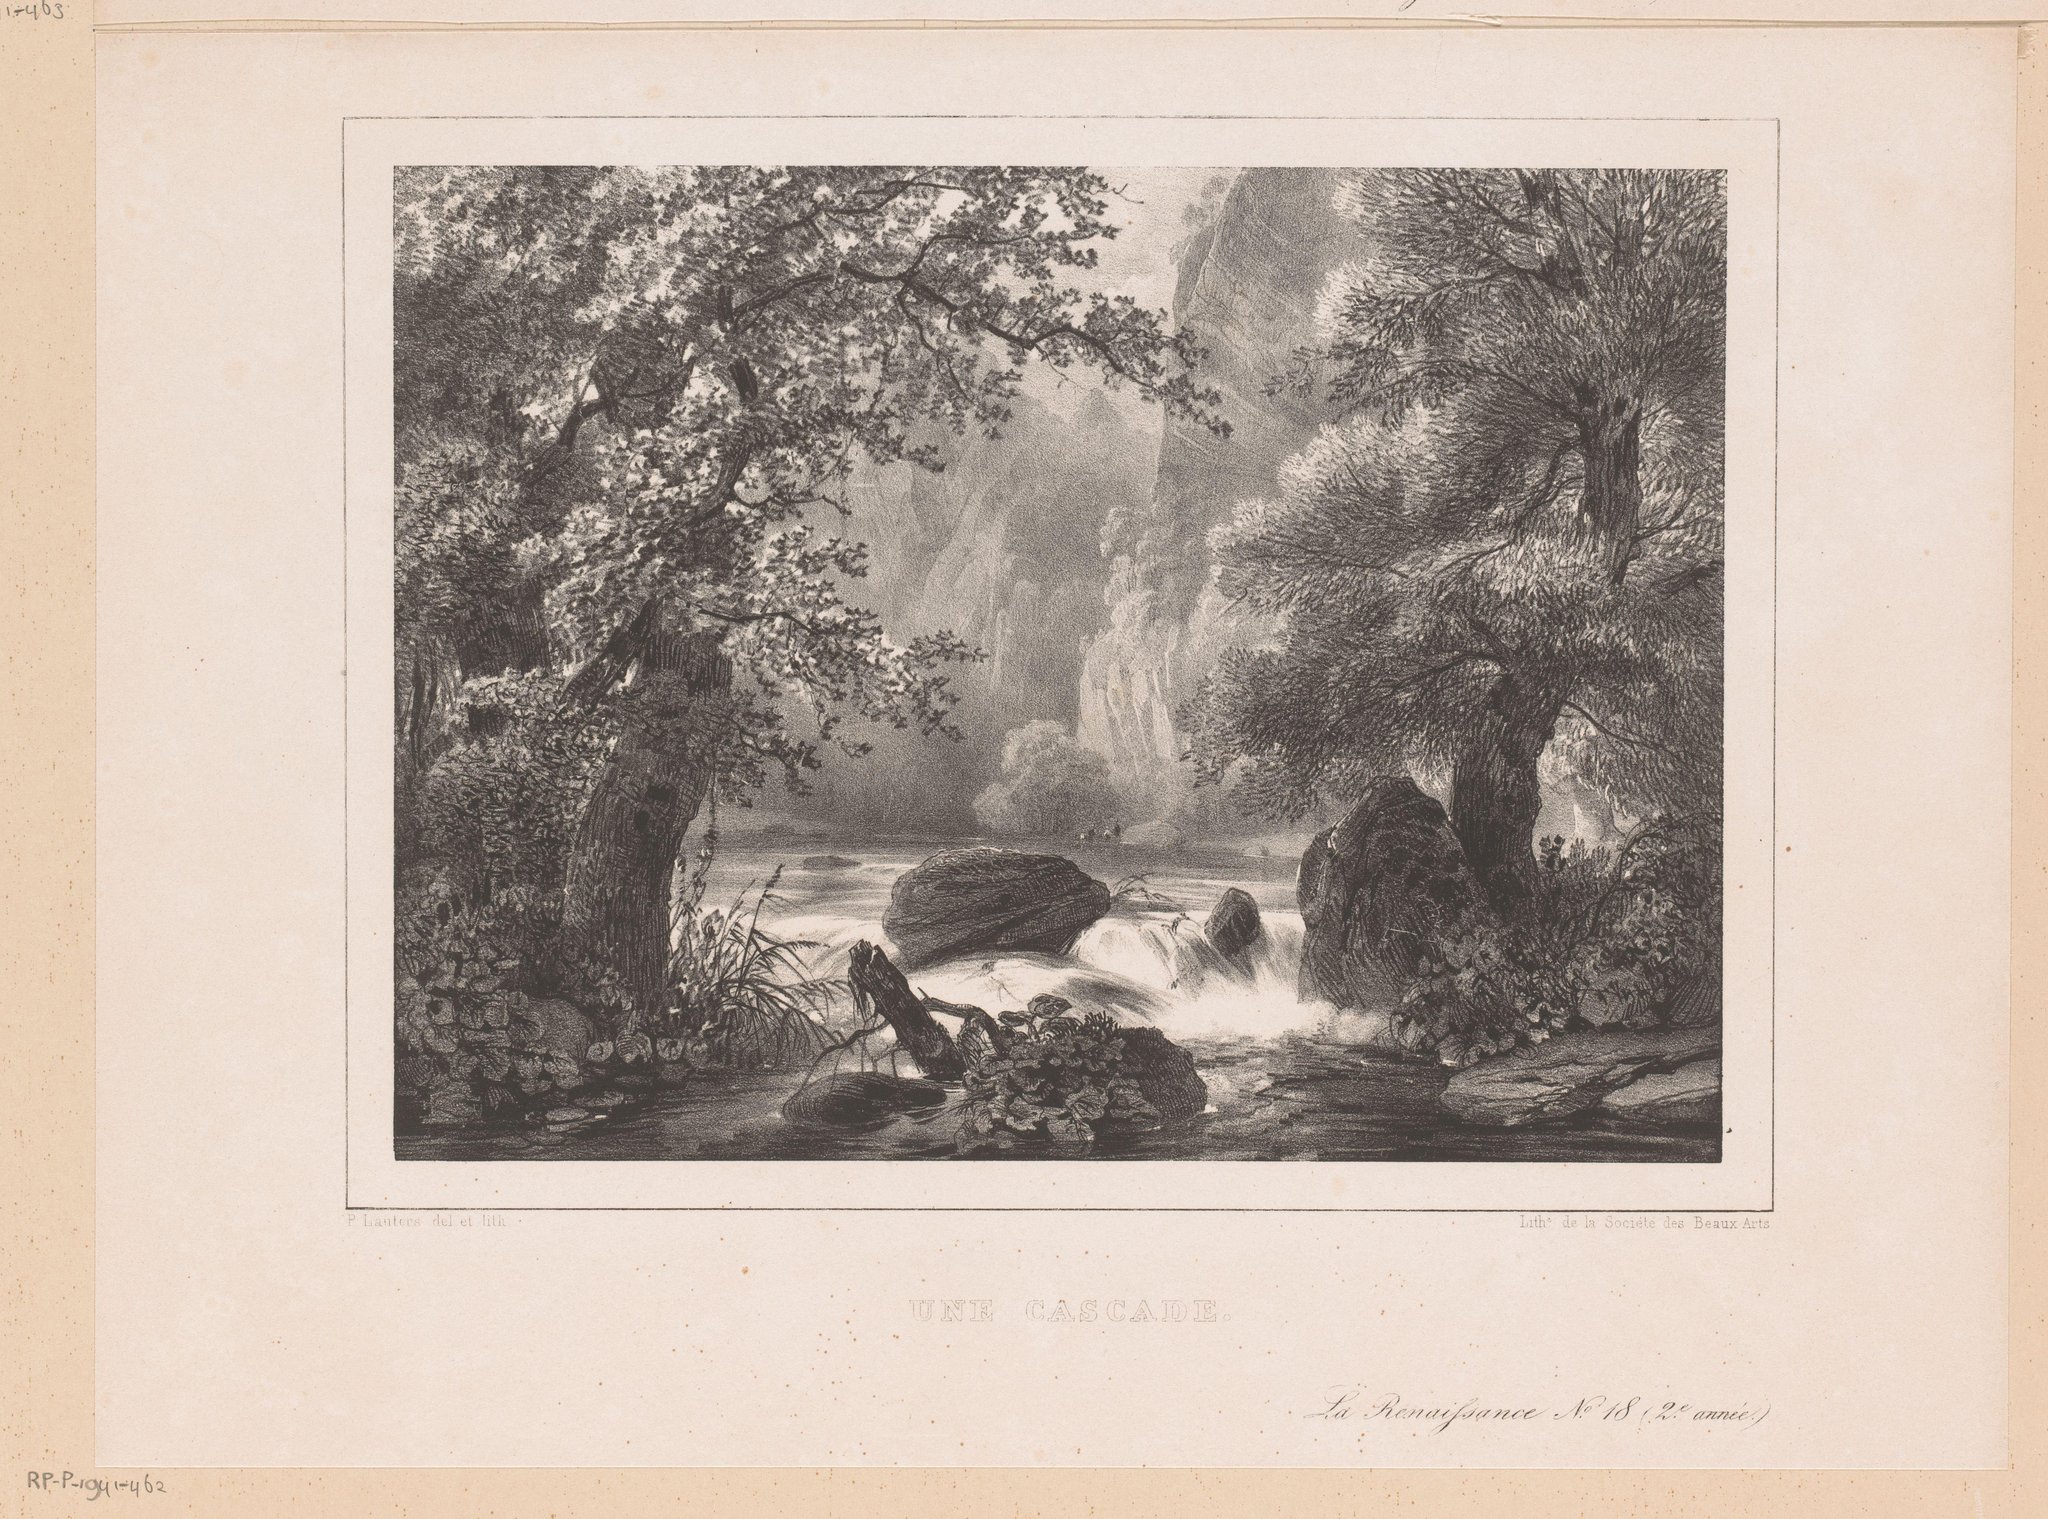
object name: print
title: Une cascade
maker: paulus lauters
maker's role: print maker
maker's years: 1806-1875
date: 1840-1841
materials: paper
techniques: lithograph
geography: brussels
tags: waterfall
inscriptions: collector's mark: Lugt 2760, collector's mark: Lugt 2228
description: Prent uit: La Renaissance. Chronique des arts et de la littérature 2 (1840-1841), pl. 18.